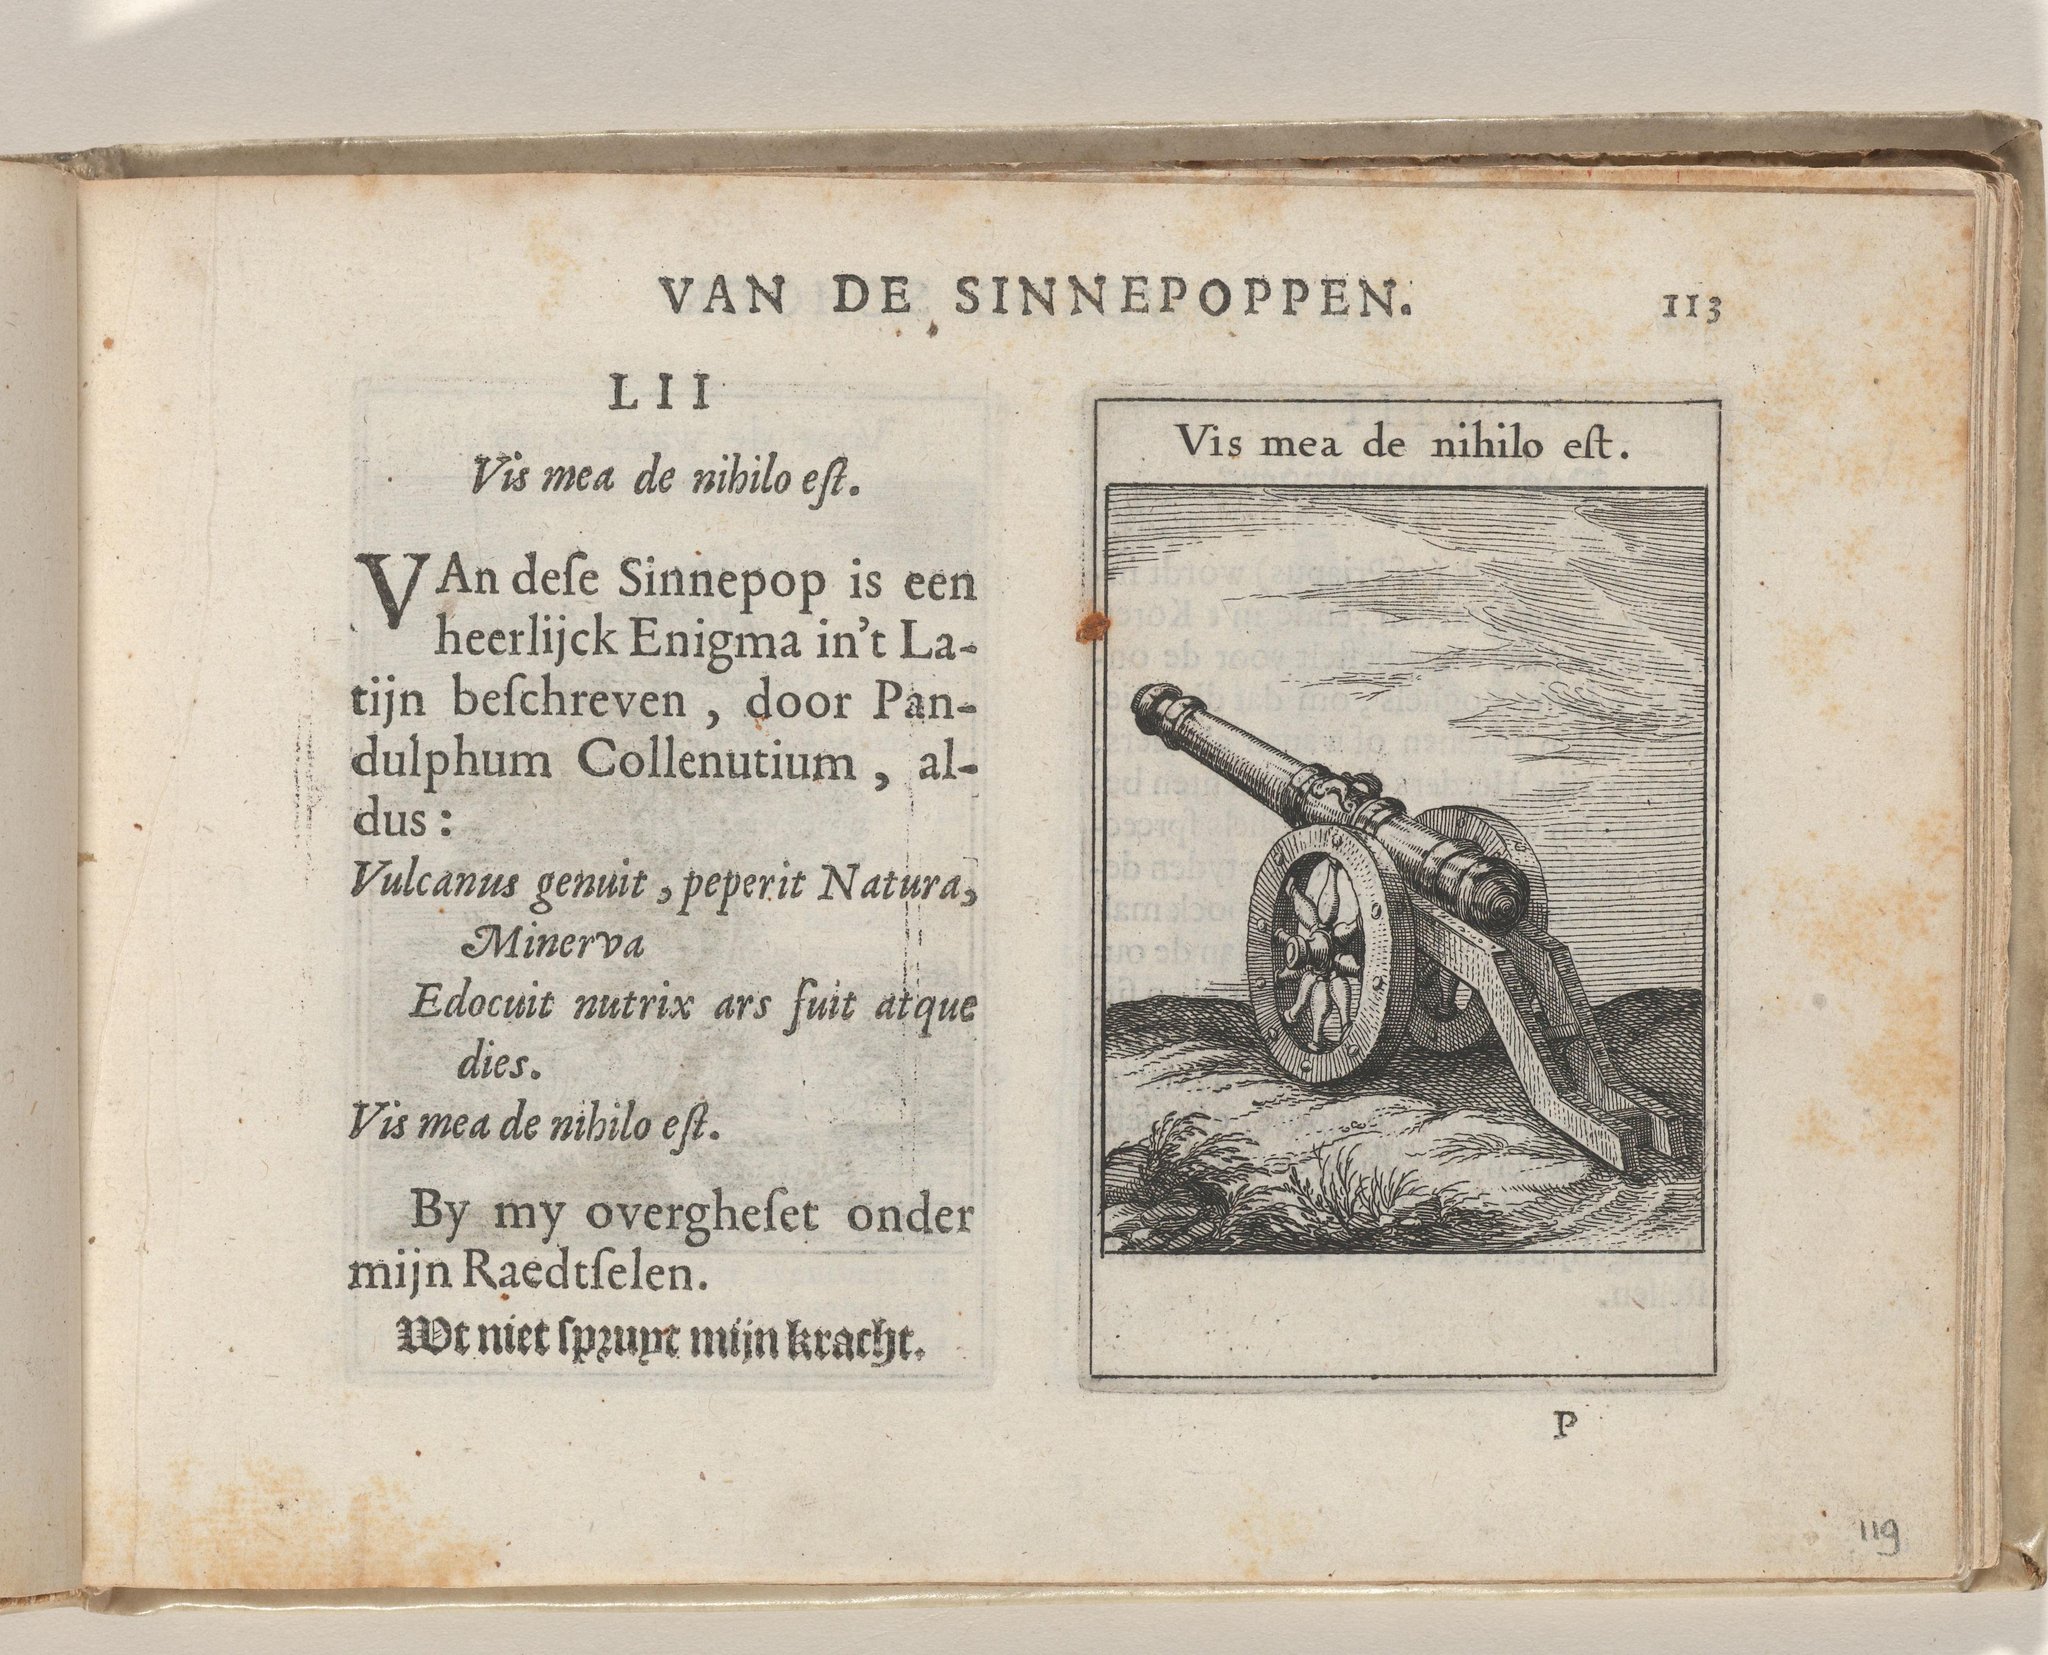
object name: print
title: LII Vis mea de nihilo est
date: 1614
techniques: engraving, printing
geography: the hague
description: LII Vis mea de nihilo est. Tweede schok. Onderdeel van 'Sinnepoppen', R. Visscher, 1614.